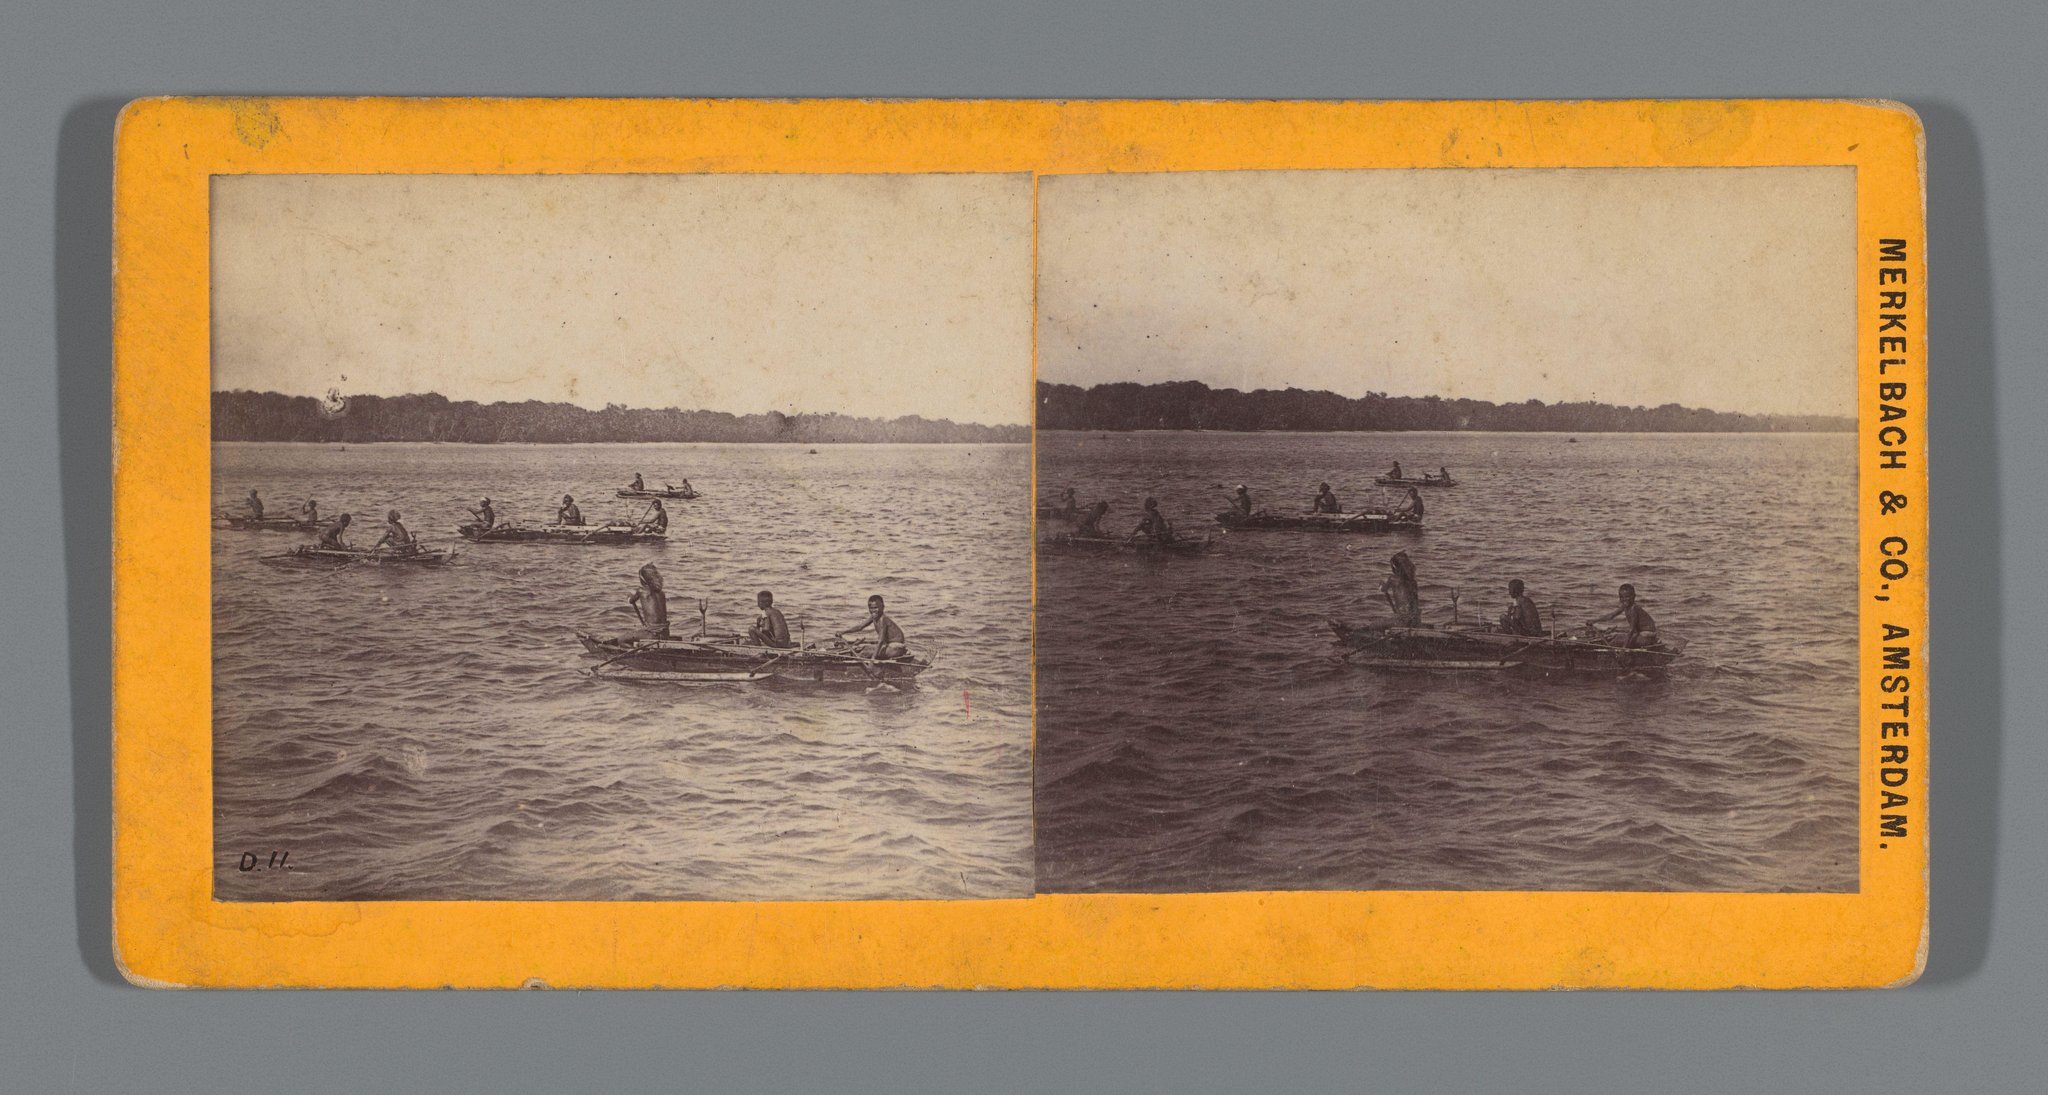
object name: stereograph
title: Aardrijkskundige Beeldengalerij, verzameld door M.J. Broekhuijsen, Hoofd eener school te Amsterdam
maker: martien johan broekhuijsen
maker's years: 1871-1956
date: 1905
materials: photographic support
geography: amsterdam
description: Onderdeel van een groep van 52 stereofoto's gebruikt in het lager onderwijs als aanvulling op schoolplaten. De gehele reeks bestond uit 274 nummers in 10 categorieën (A t/m K).